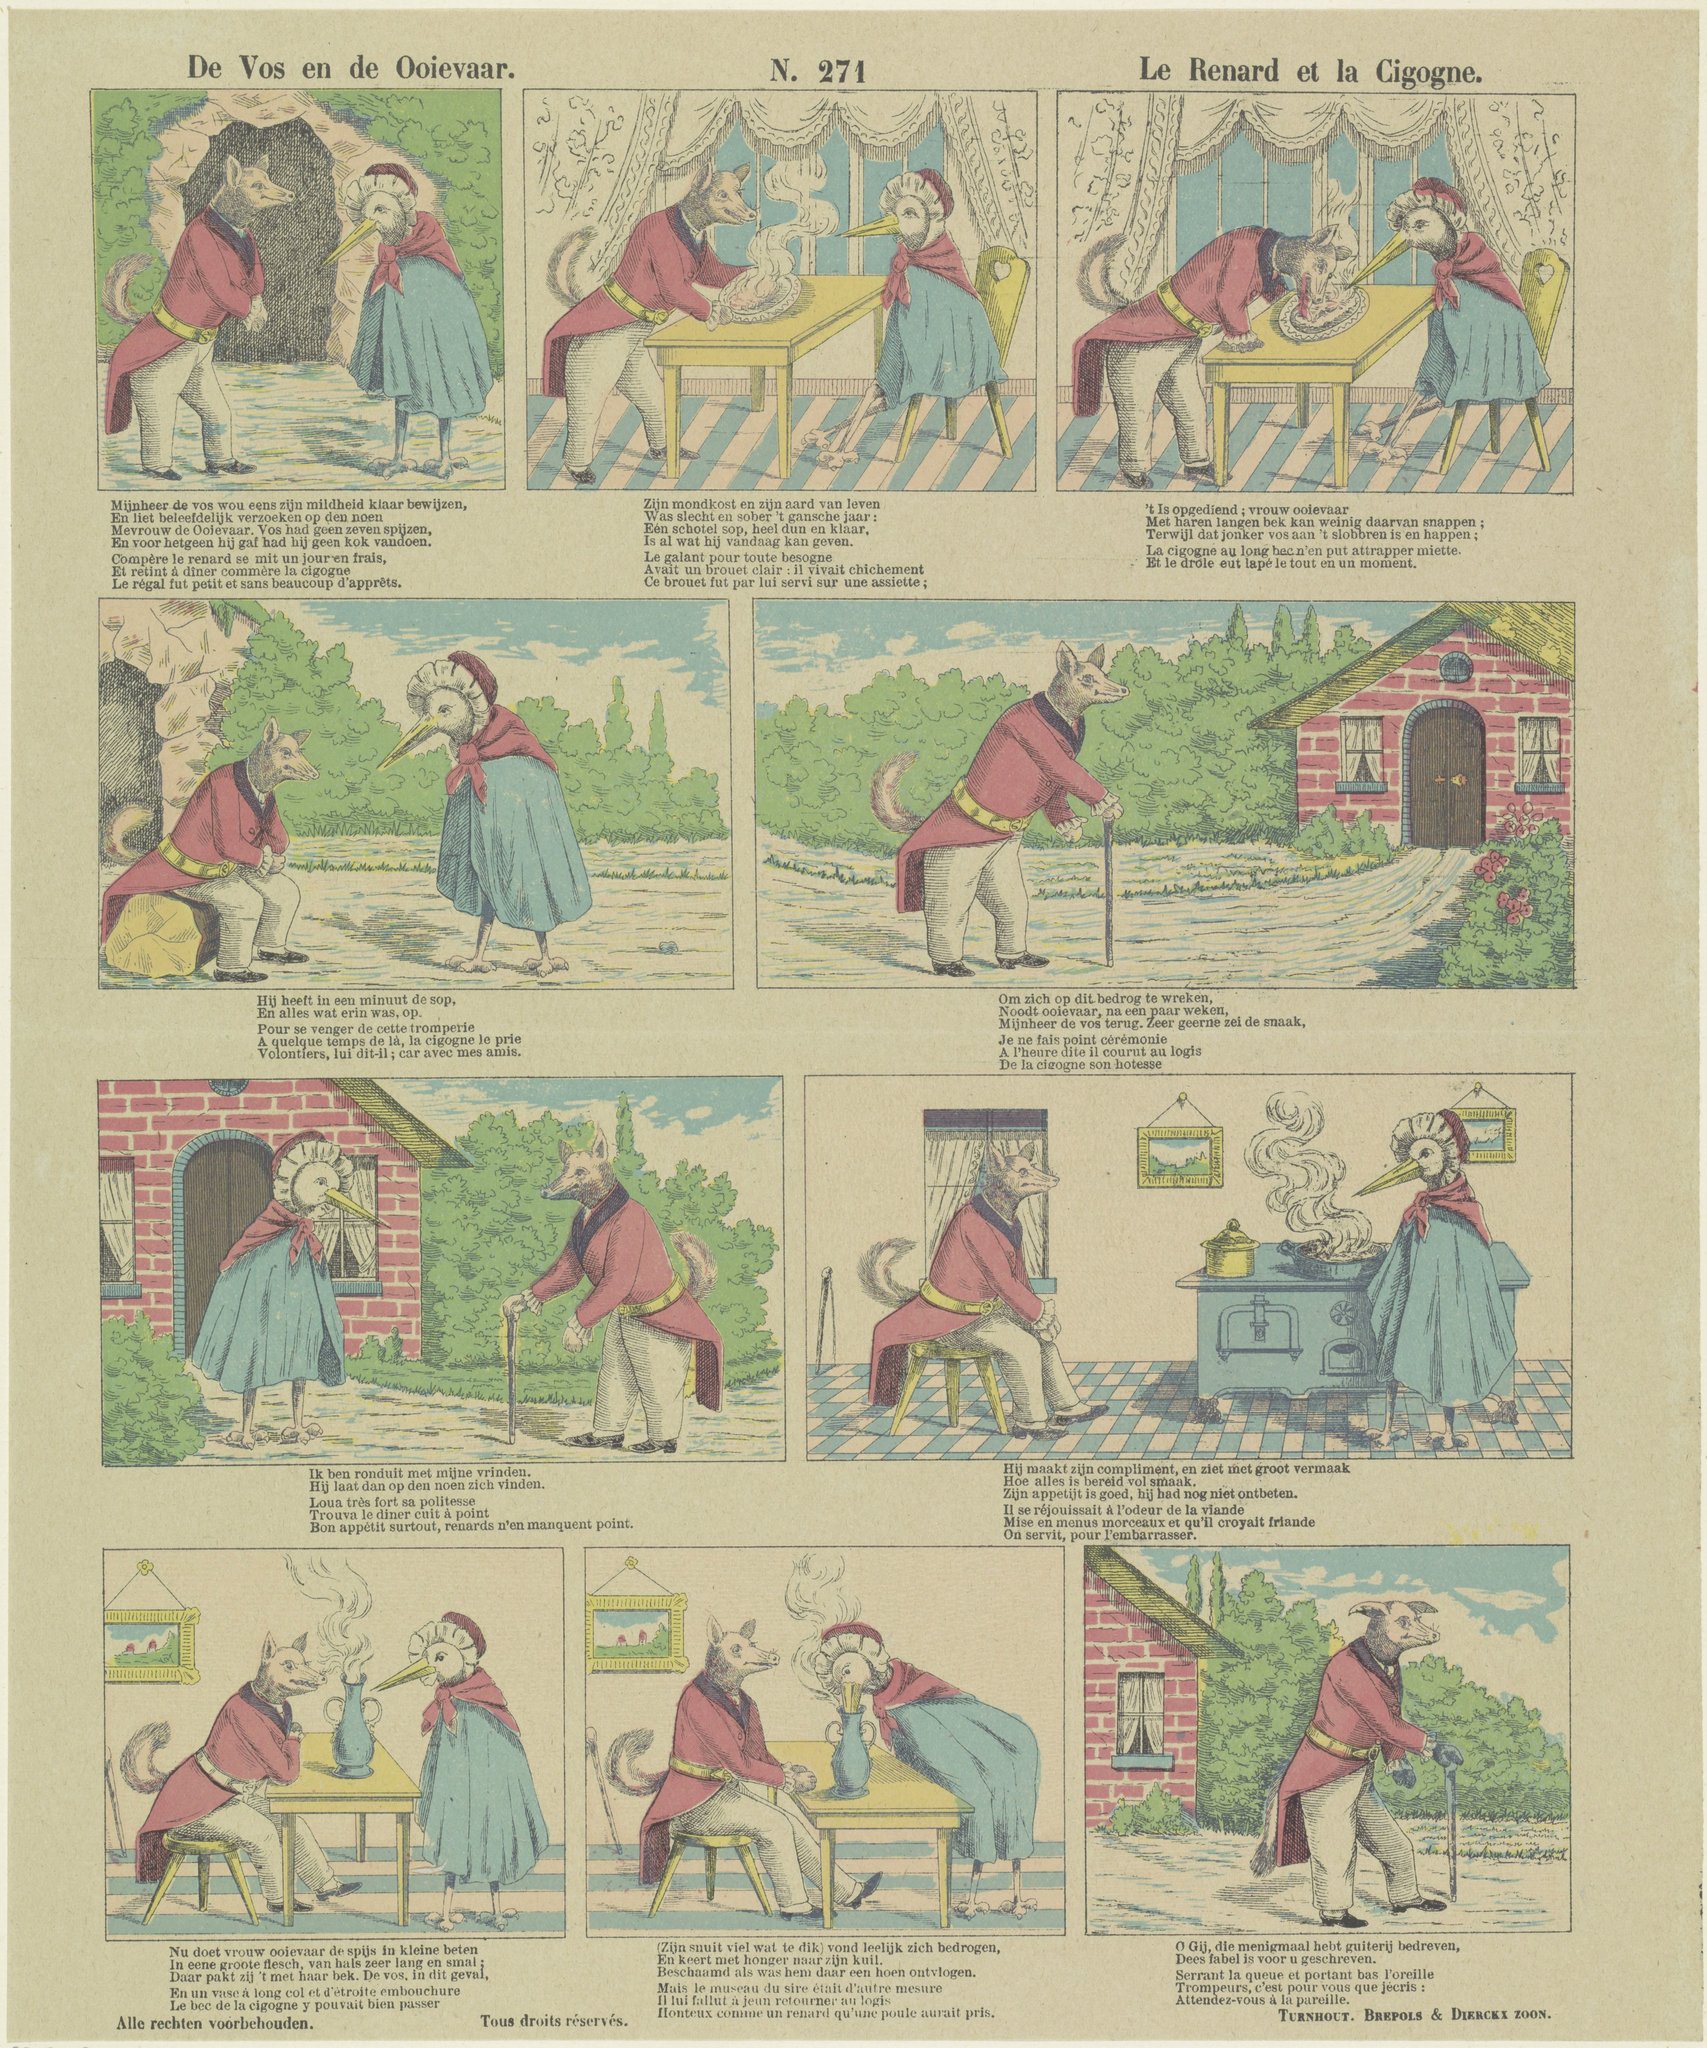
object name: popular print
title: De vos en de ooievaar / Le renard et la cigogne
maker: Anonymous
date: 1833-1911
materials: paper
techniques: lithograph, letterpress printing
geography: turnhout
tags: shore-birds and wading-birds: stork, animals acting as human beings, fables, beasts of prey, predatory animals: fox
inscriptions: collector's mark: Lugt 2760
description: Blad met 10 voorstellingen uit de fabel van de vos en de ooievaar. Onder elke afbeelding een onderschrift in het Nederlands en in het Frans. Genummerd midden boven: N. 271.